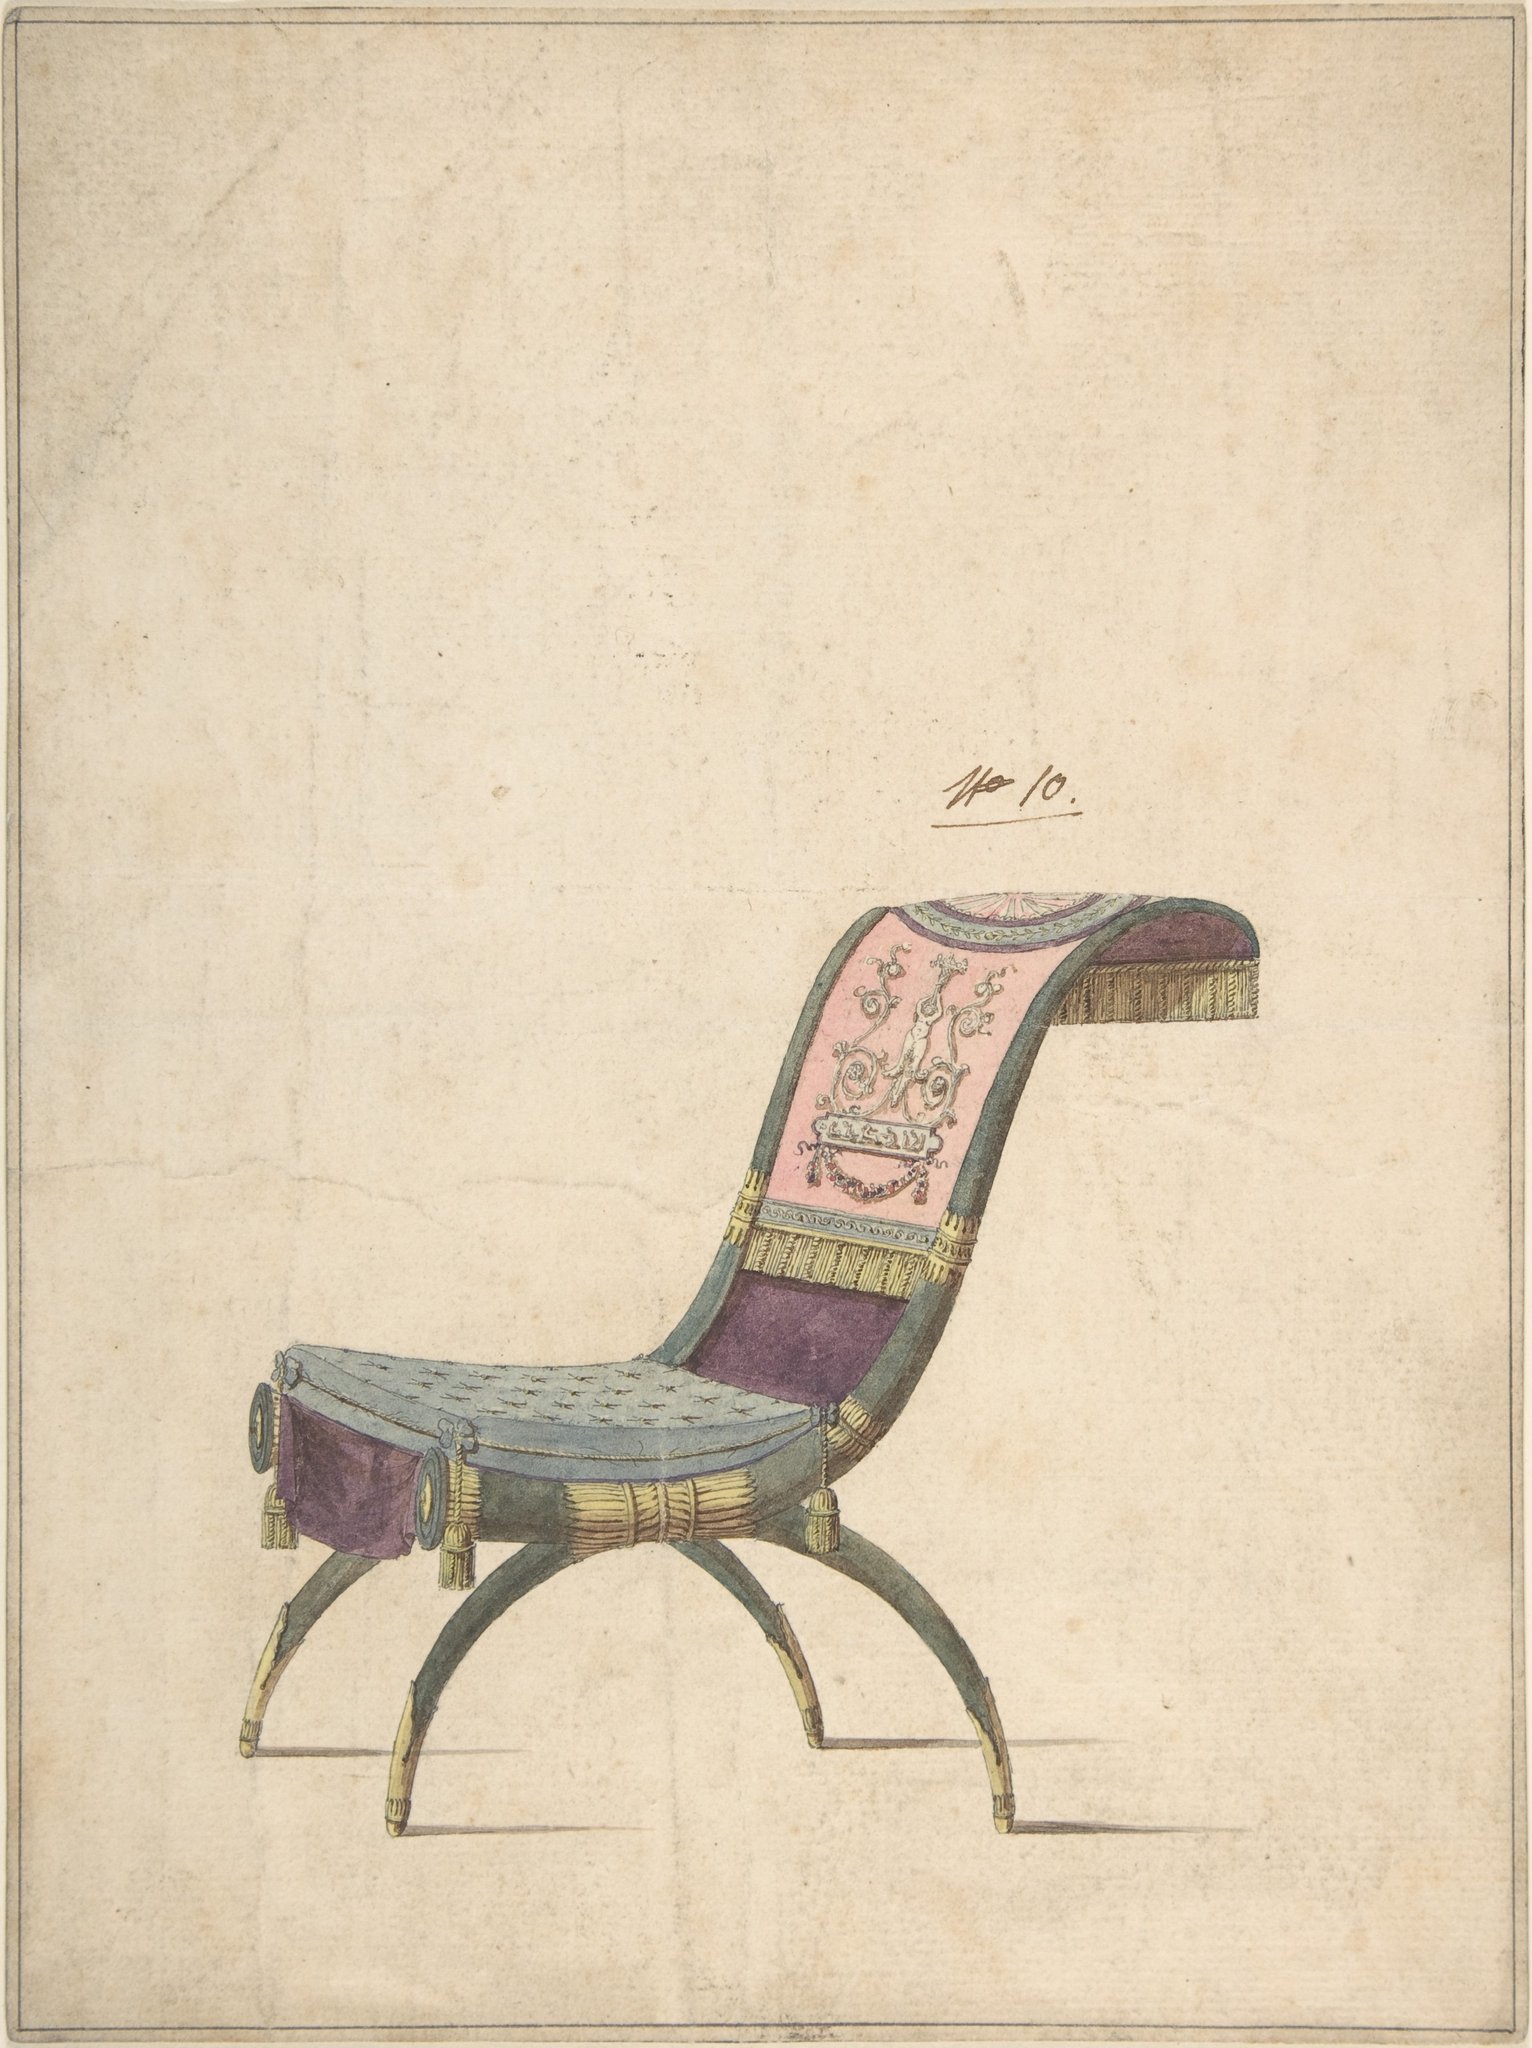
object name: drawing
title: Design for an Empire Chair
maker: anonymous, french, 18th century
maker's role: artist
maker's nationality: french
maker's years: 1700-1800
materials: ink, watercolor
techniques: pen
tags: chairs